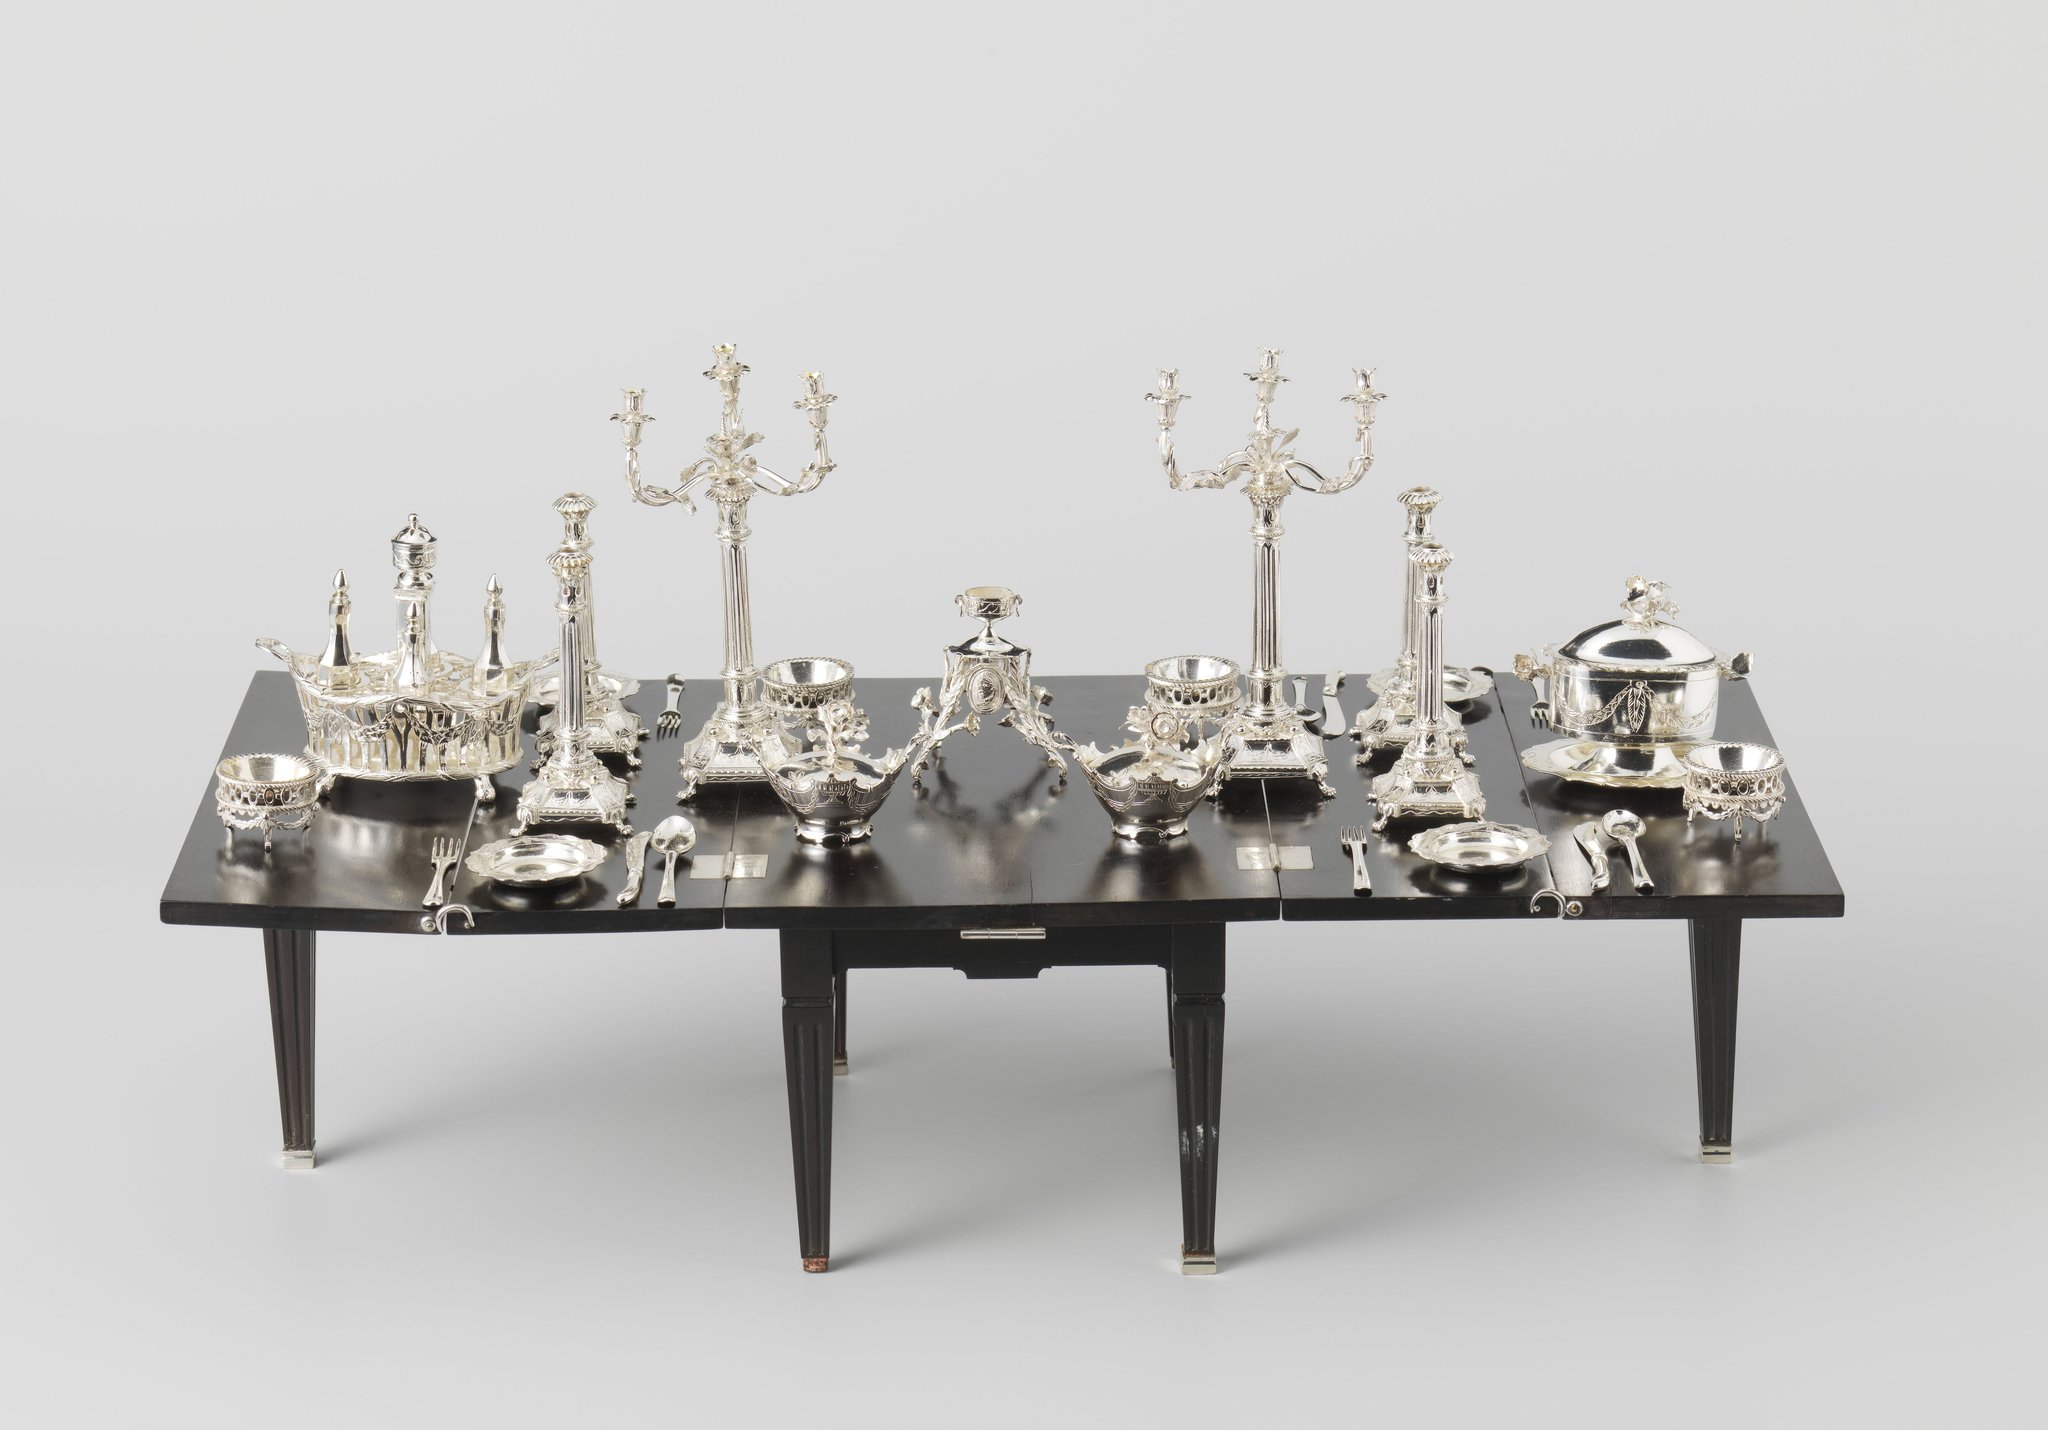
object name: miniature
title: Fles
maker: hendrik duller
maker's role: silversmith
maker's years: 1749-1820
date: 1784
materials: silver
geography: amsterdam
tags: container of glass: bottle, jar, vase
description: Fles behorend tot een olie- en azijnstel (BK-NM-11177-122). De fles is achthoekig en heeft een lange, smalle hals. De fles heeft een schenktuit en een knopvormige deksel. De fles staat samen met drie identieke flessen (BK-NM-11177-122-c, BK-NM-11177-122-d, BK-NM-11177-122-e) op een plateau (BK-NM-11177-122-b) in een mand (BK-NM-11177-122-a).